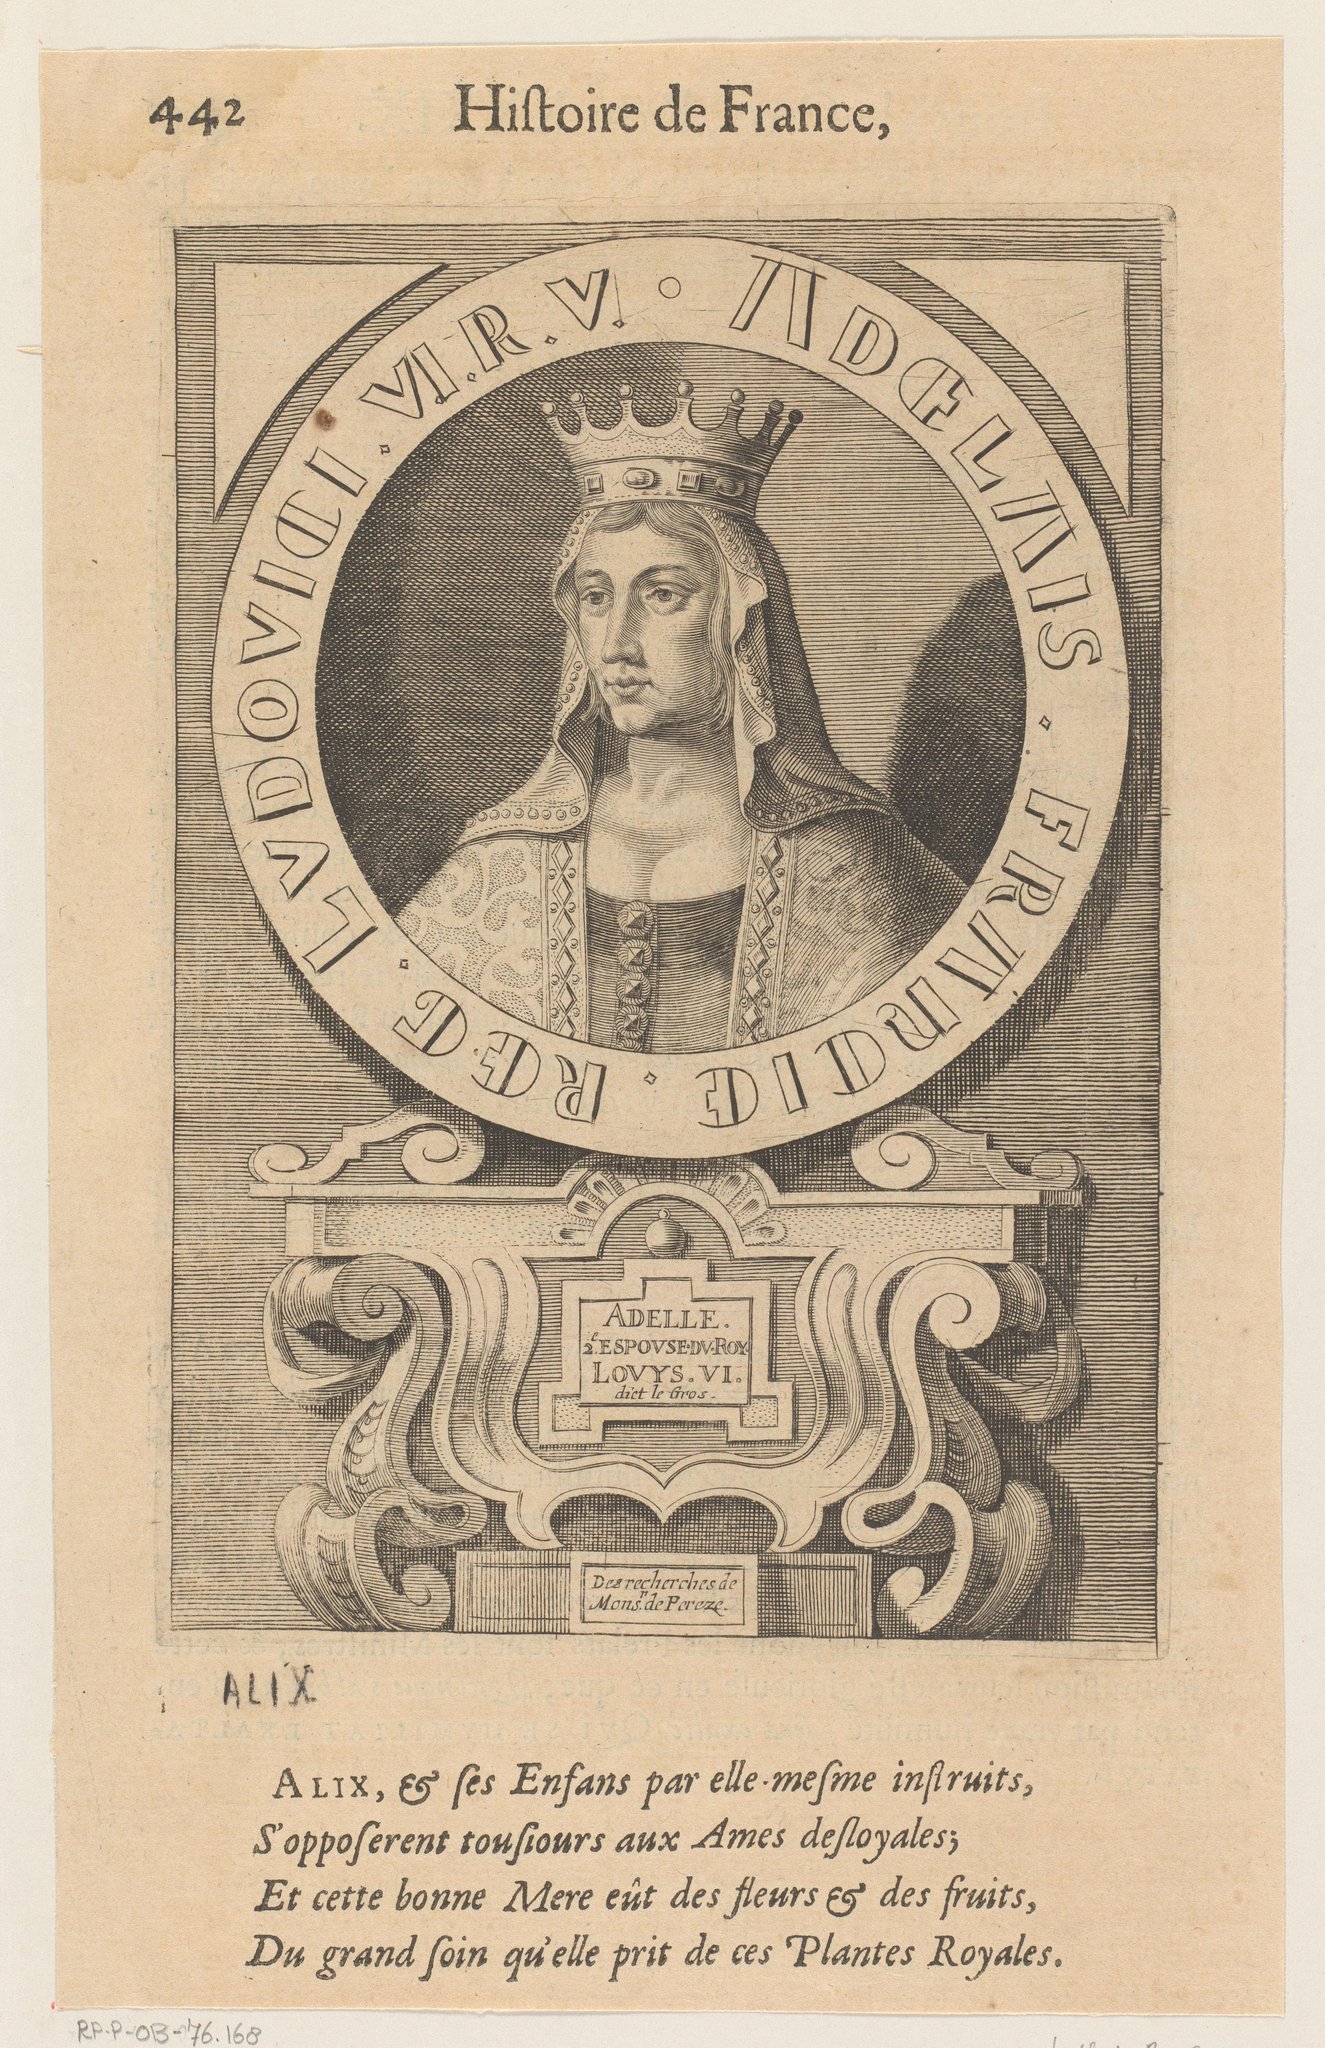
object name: print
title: Portret van Adelheid van Maurienne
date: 1643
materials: paper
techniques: engraving, letterpress printing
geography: paris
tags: historical persons, queen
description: Prent uit: Eudes de Mézeray, François. Histoire de France, depuis Faramond jusqu’au regne de Louis le Juste (...). 3 dln. Parijs: Mathieu Guillemot, 1643, dl. 1. Prent waarschijnlijk voor het eerst verschenen in: Bie, Jacques de. Les vrais portraits des rois de France (...). Parijs: Jacques de Bie en Pierre Rocolet, 1634. Prent ook gebruikt in latere publicaties.